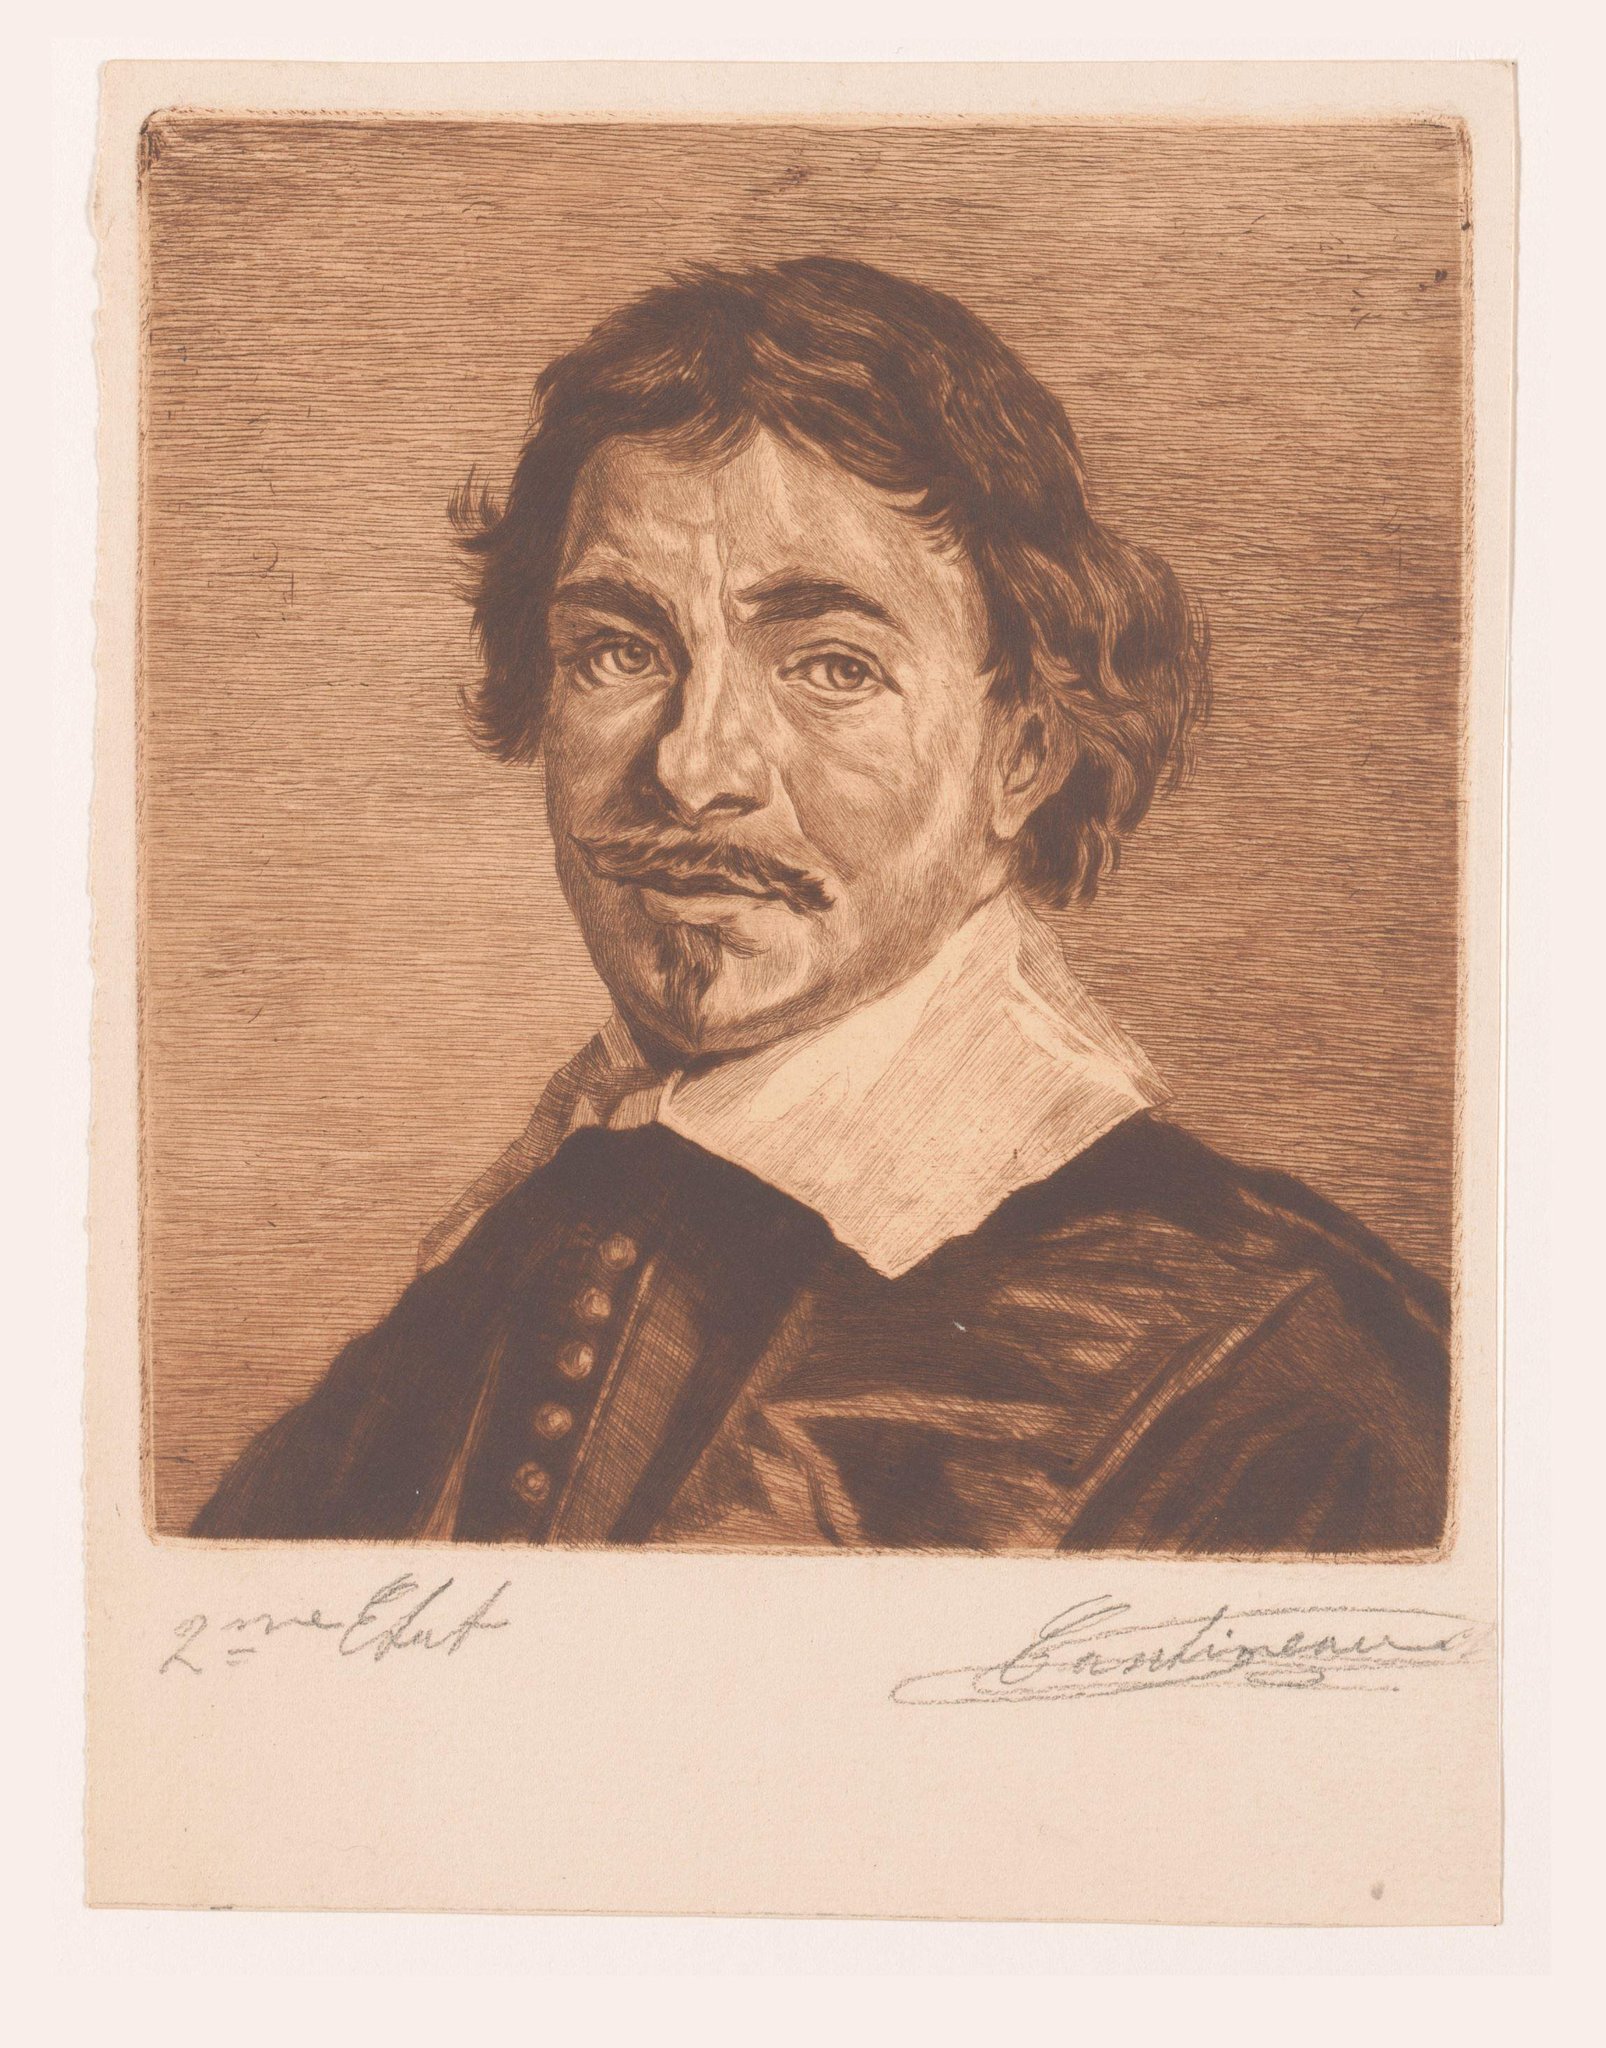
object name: print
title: Portret van Frans Hals, naar een zelfportret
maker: mary hector rupert cantineau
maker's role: draughtsman, print maker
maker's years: 1875-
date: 1885-1909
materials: paper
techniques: drypoint, etching, intaglio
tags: antwerp, draughtsman, frans hals, portrait, self-portrait of artist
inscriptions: collector's mark: Lugt 2228, annotation: ‘2me état’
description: Sterfdatum prentmaker onbekend. Derhalve is voor bepaling van de rechten van dit object de verwervingsdatum aangehouden.